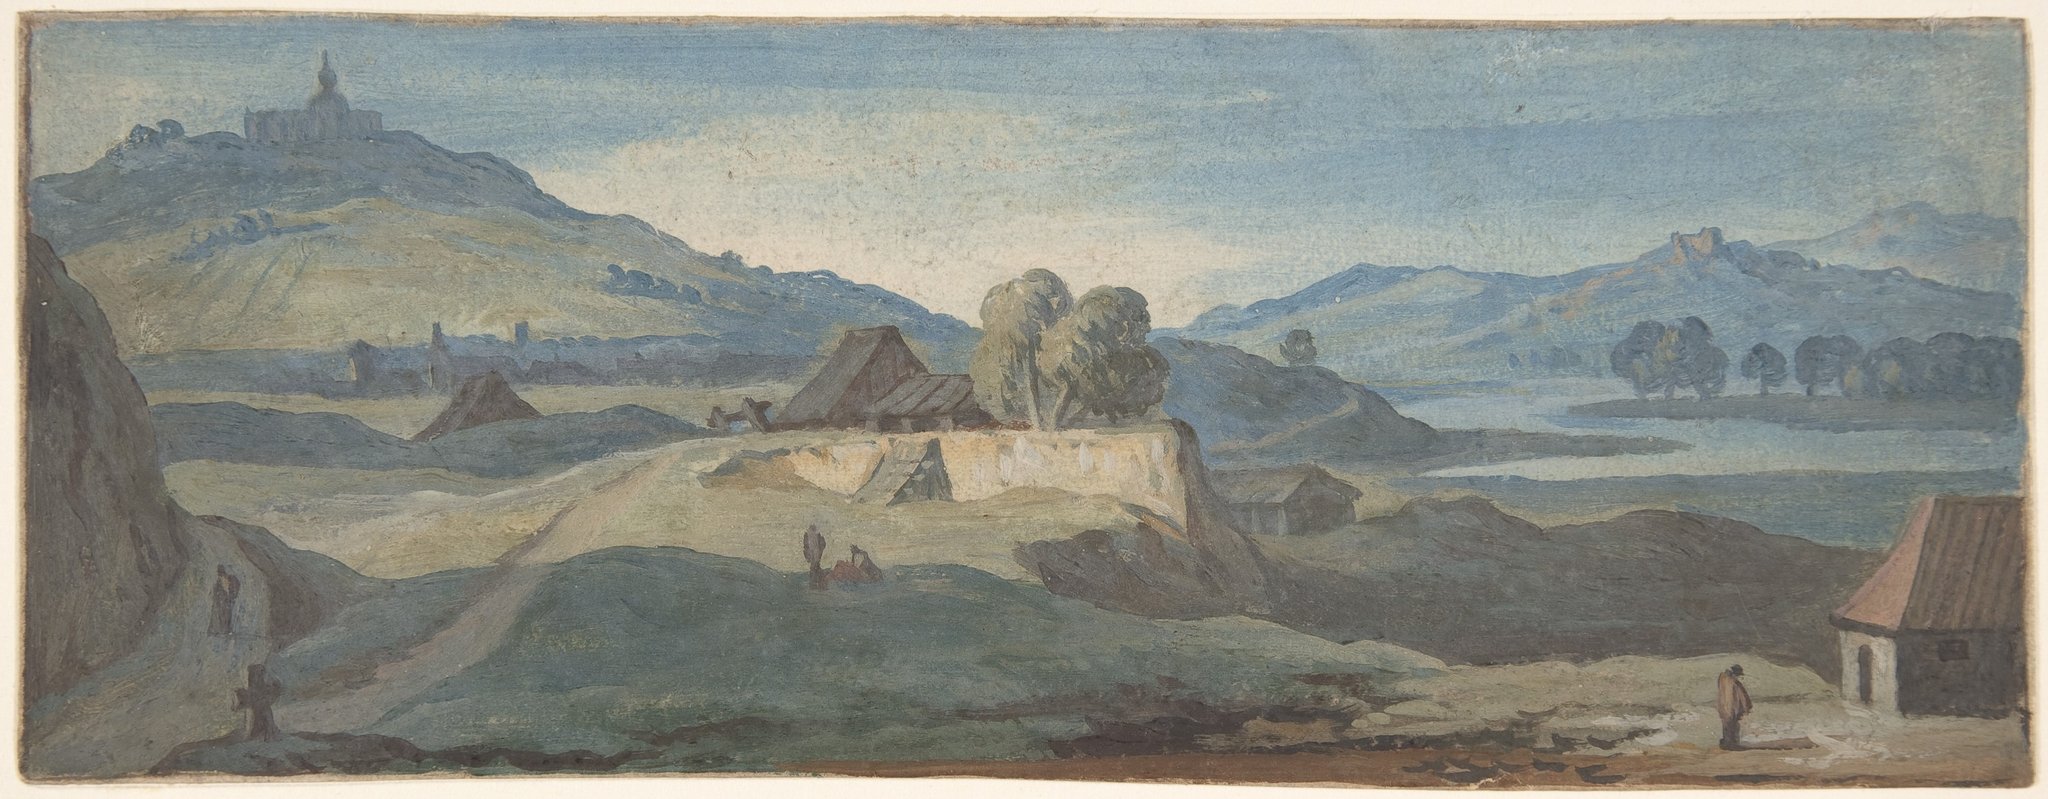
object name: drawing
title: Landscape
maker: jan frans van bloemen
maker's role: artist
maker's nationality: flemish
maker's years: 1662-1749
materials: gouache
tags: houses,hills,landscapes,trees